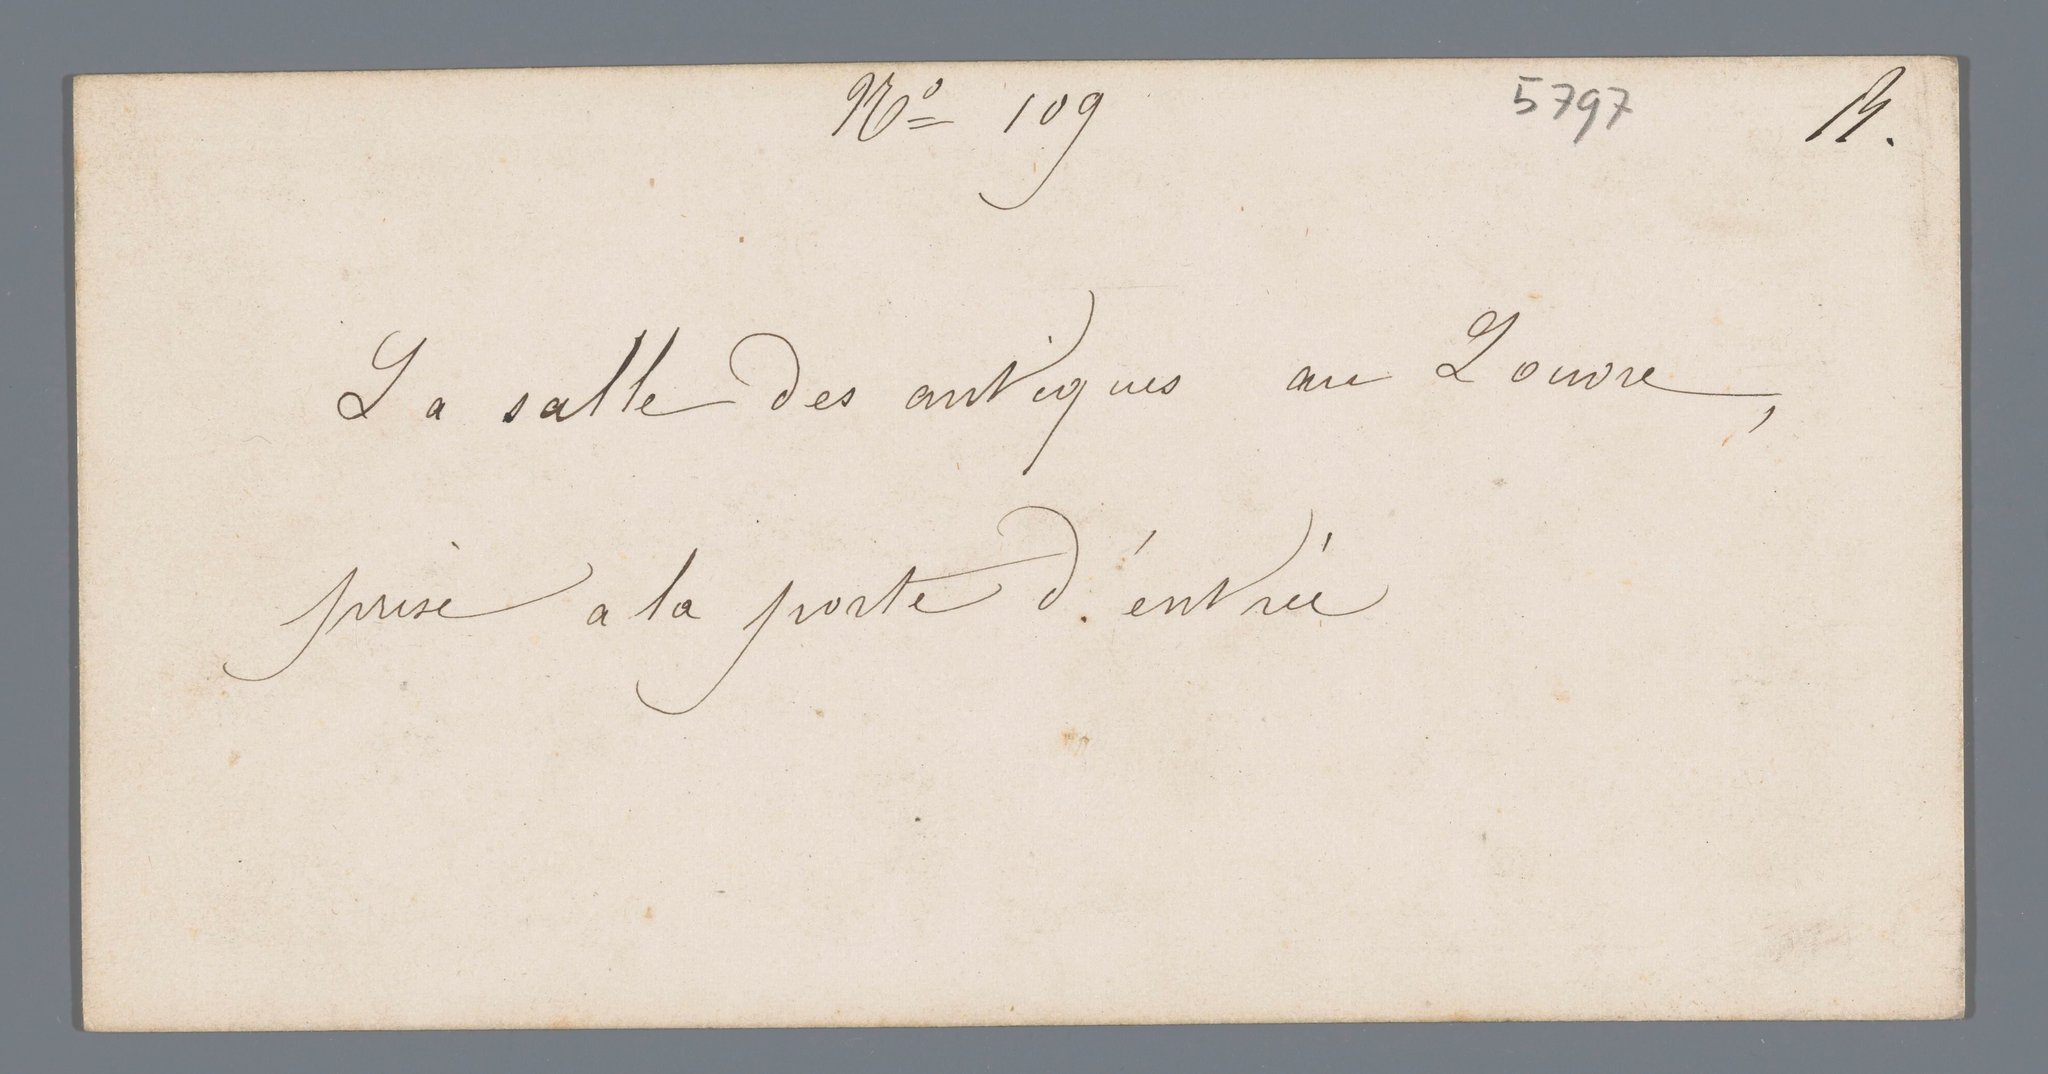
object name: stereograph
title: Interieur van een museumzaal in het Musée du Louvre in Parijs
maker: Anonymous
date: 1855-1860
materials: cardboard, photographic support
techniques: albumen print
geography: louvre museum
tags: permanent exhibition, museum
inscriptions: number: ‘No. 109 14.’, inscription: ‘La salle des antiques au Louvre, prise a la porte d'entrée’